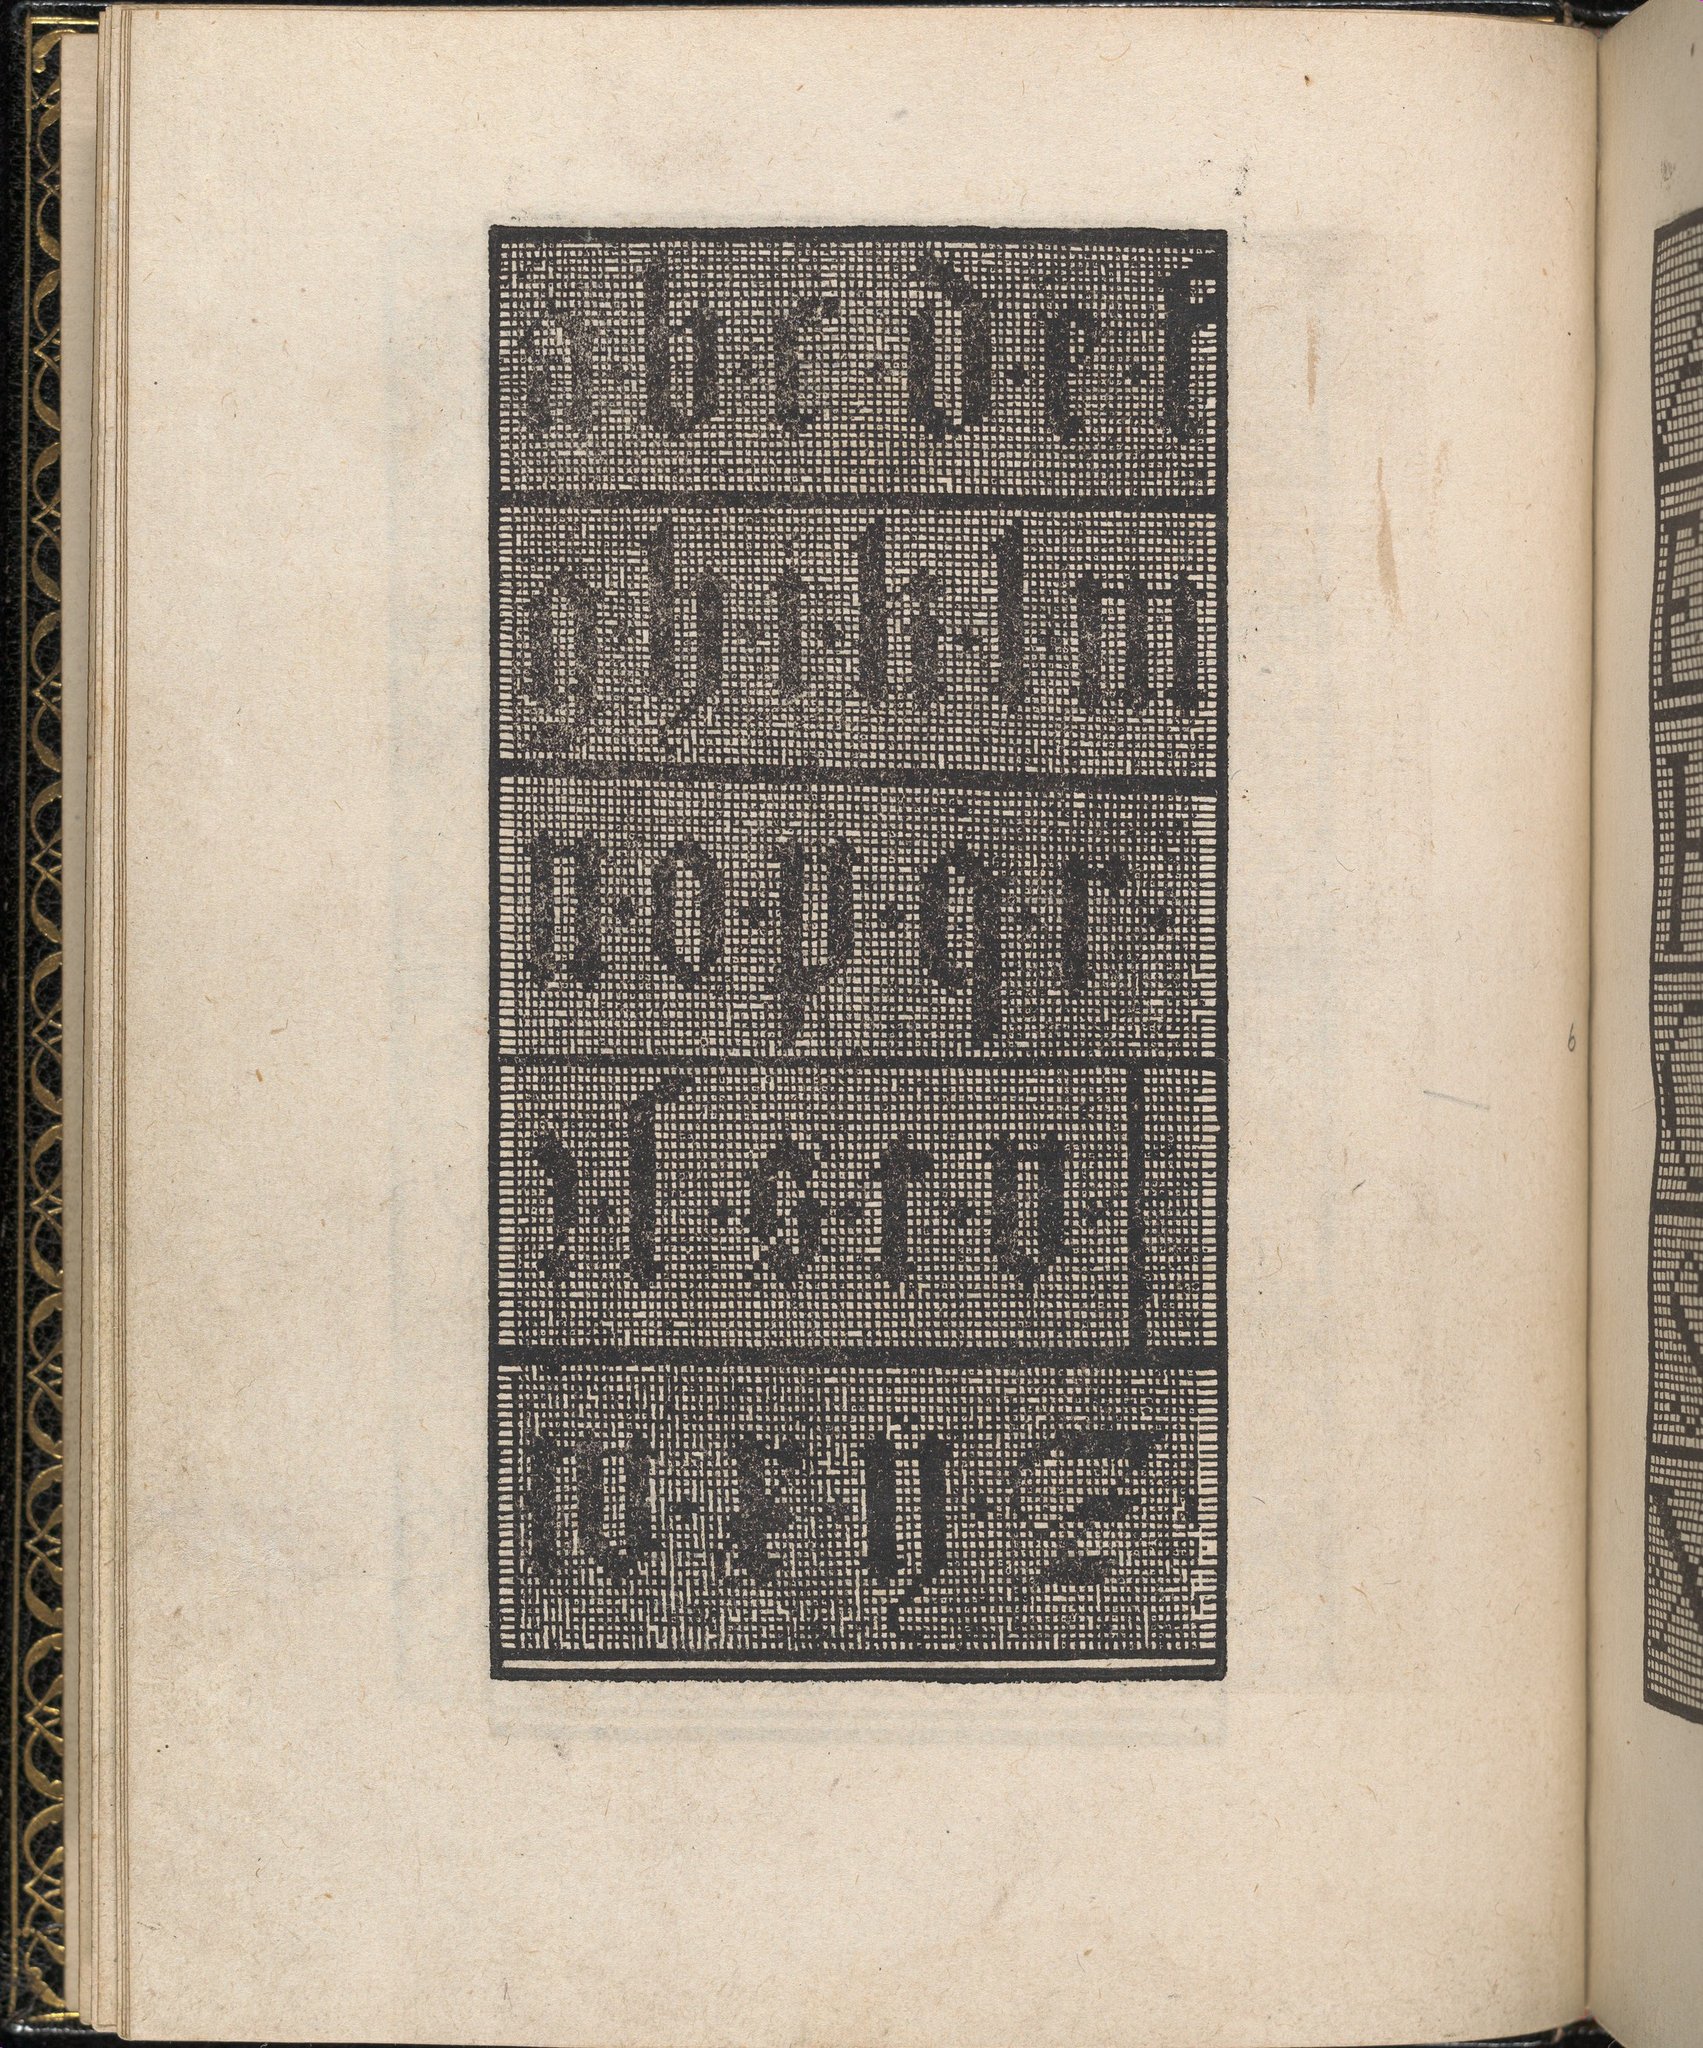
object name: book print ornament architecture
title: Page from Ein new kunstlich Modelbuch...(Page 6v)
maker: peter quentel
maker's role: publisher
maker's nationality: german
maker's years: 1500-1550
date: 1544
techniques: woodcut